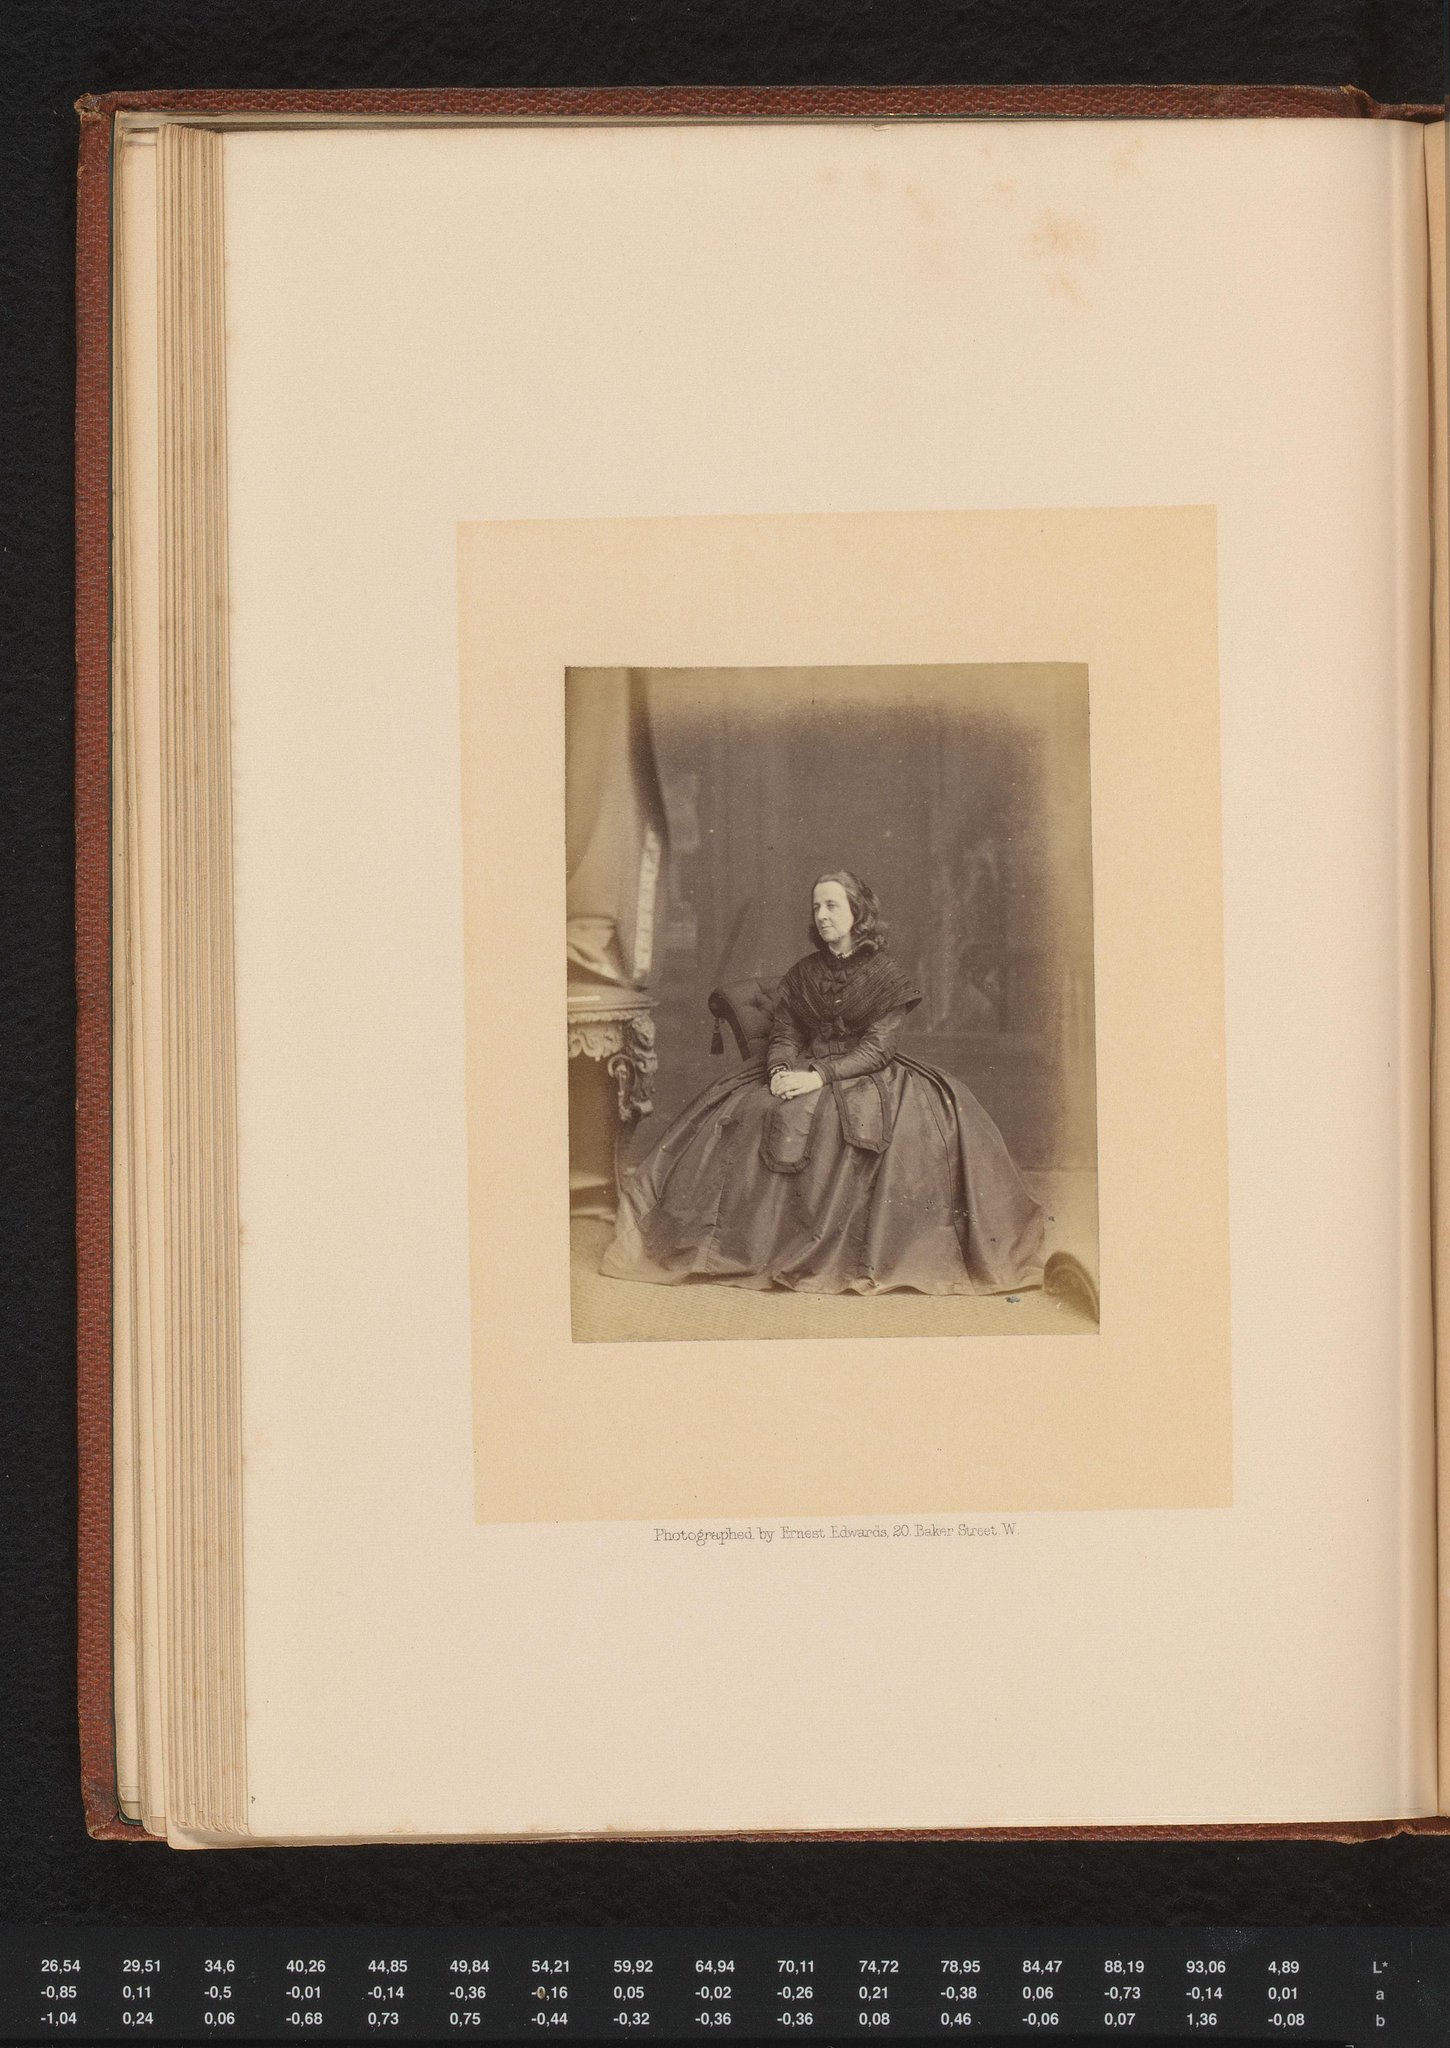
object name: page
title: Portret van de dichteres en journaliste Bessie Rayner Parkes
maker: ernest edwards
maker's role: fotograaf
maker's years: 1837-1903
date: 1861-1866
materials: paper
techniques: albumen print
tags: historical persons - bb - woman, portrait of a writer